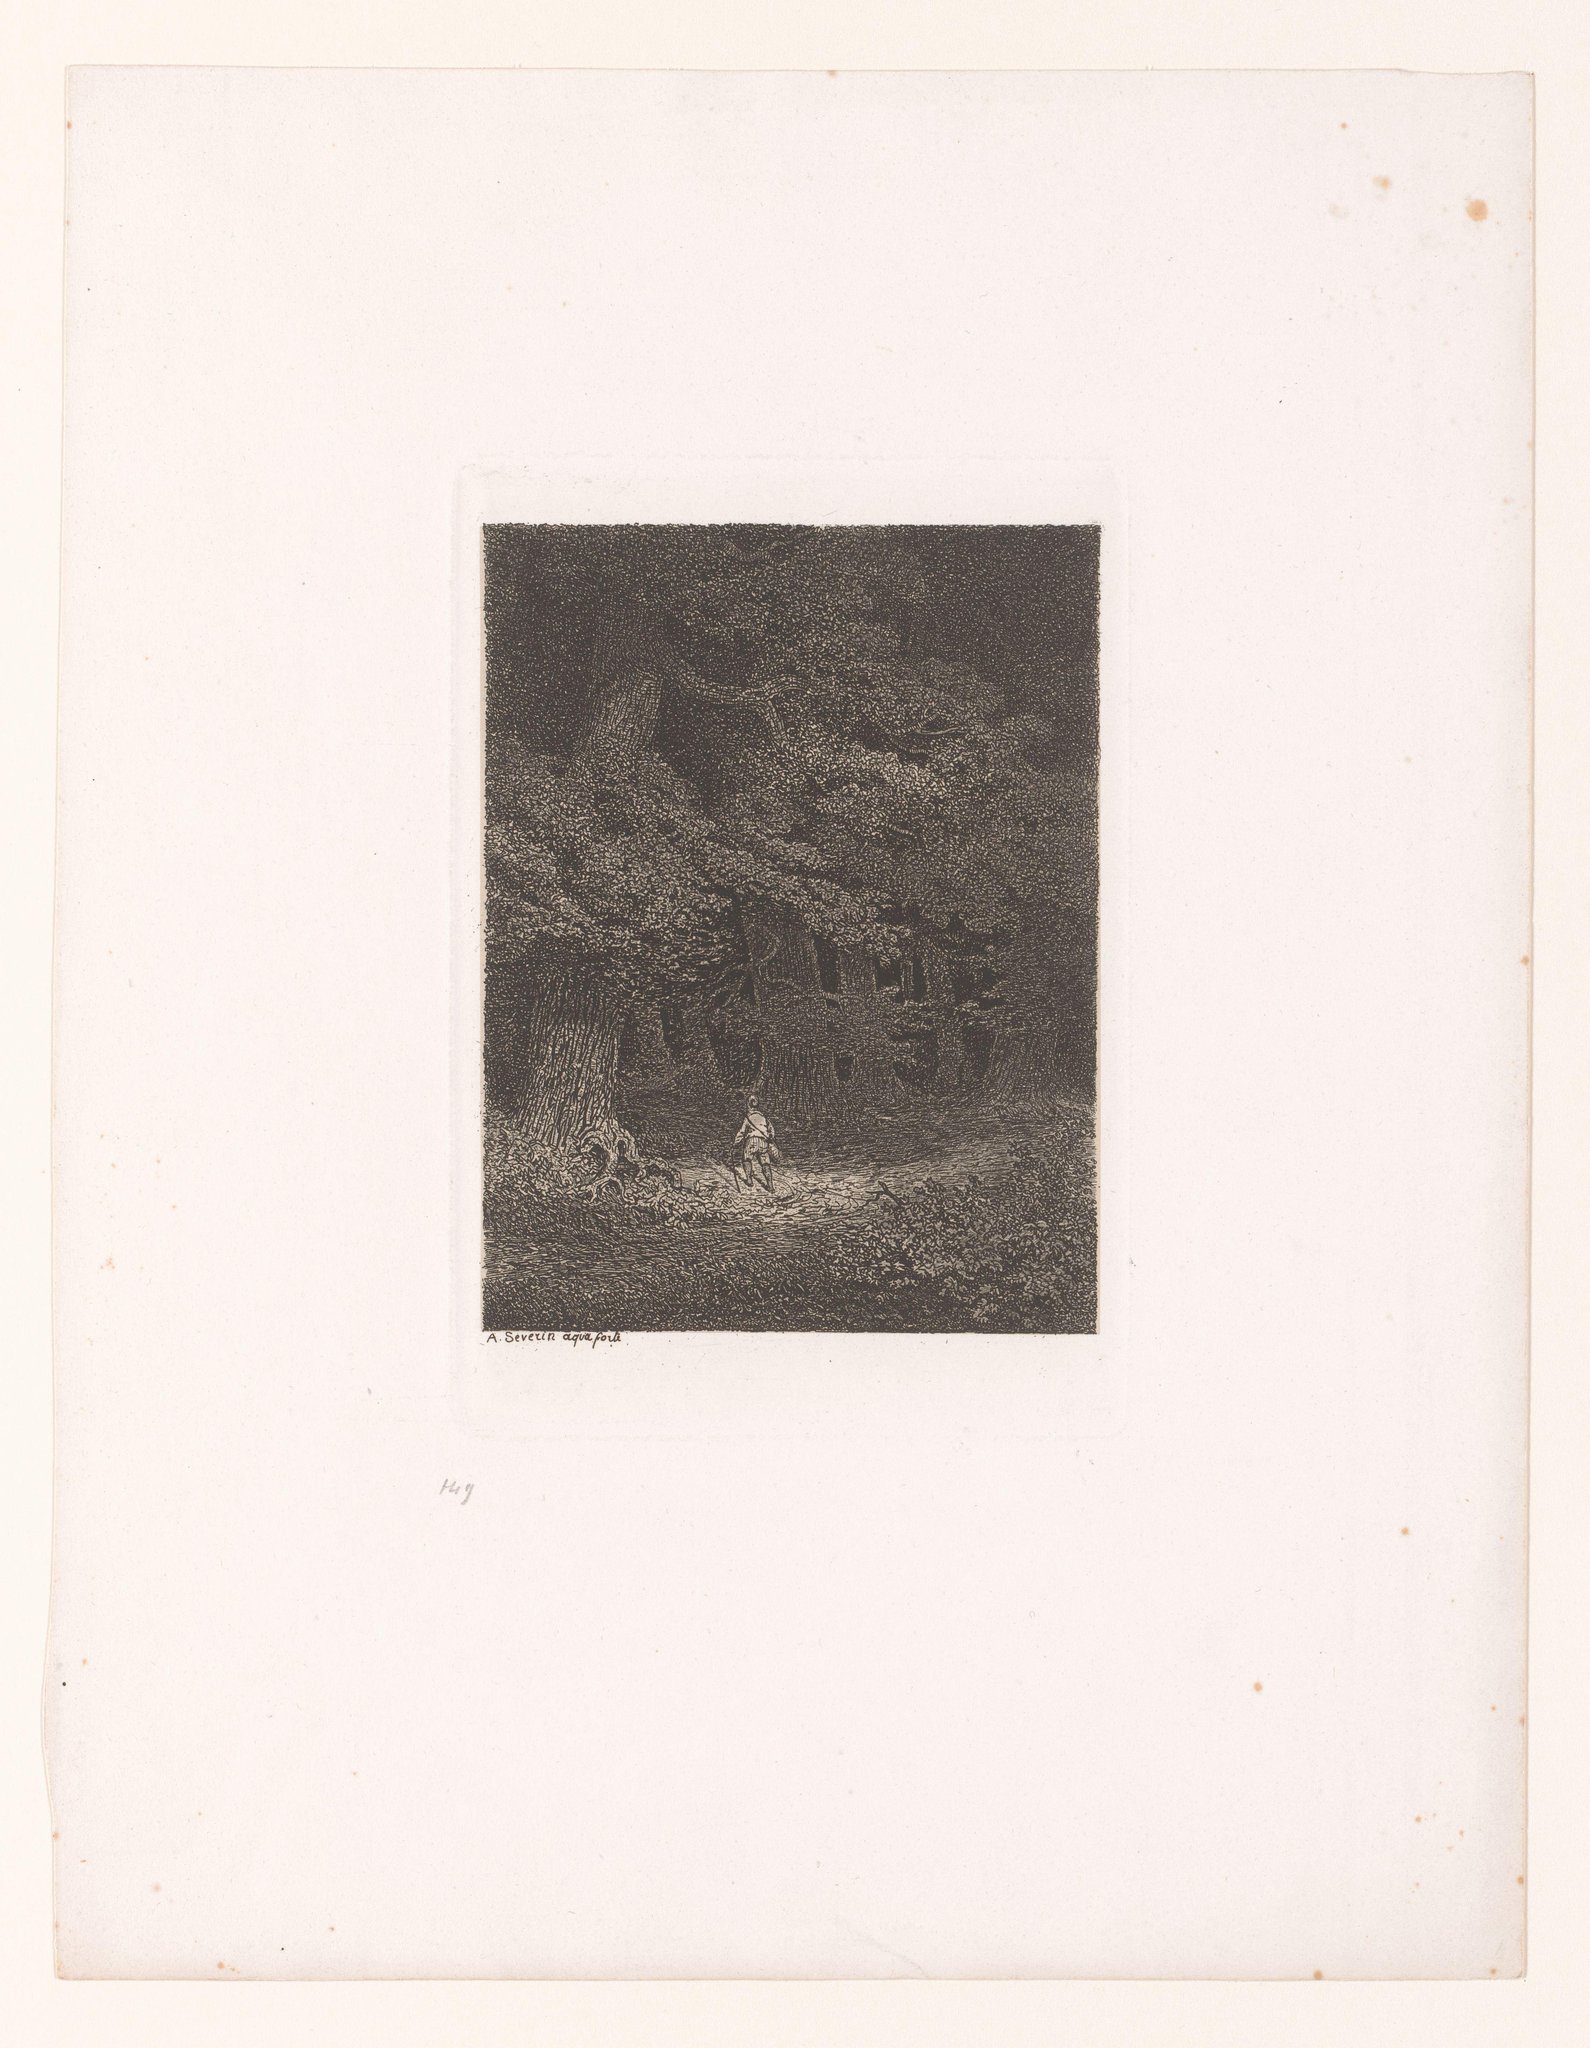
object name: print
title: Gravures à l'eau-forte par A. Severin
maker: antoine severin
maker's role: print maker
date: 1851-1852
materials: paper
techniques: etching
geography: brussels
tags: hunter, deciduous forest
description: Prent maakt deel uit van een serie van negen prenten.